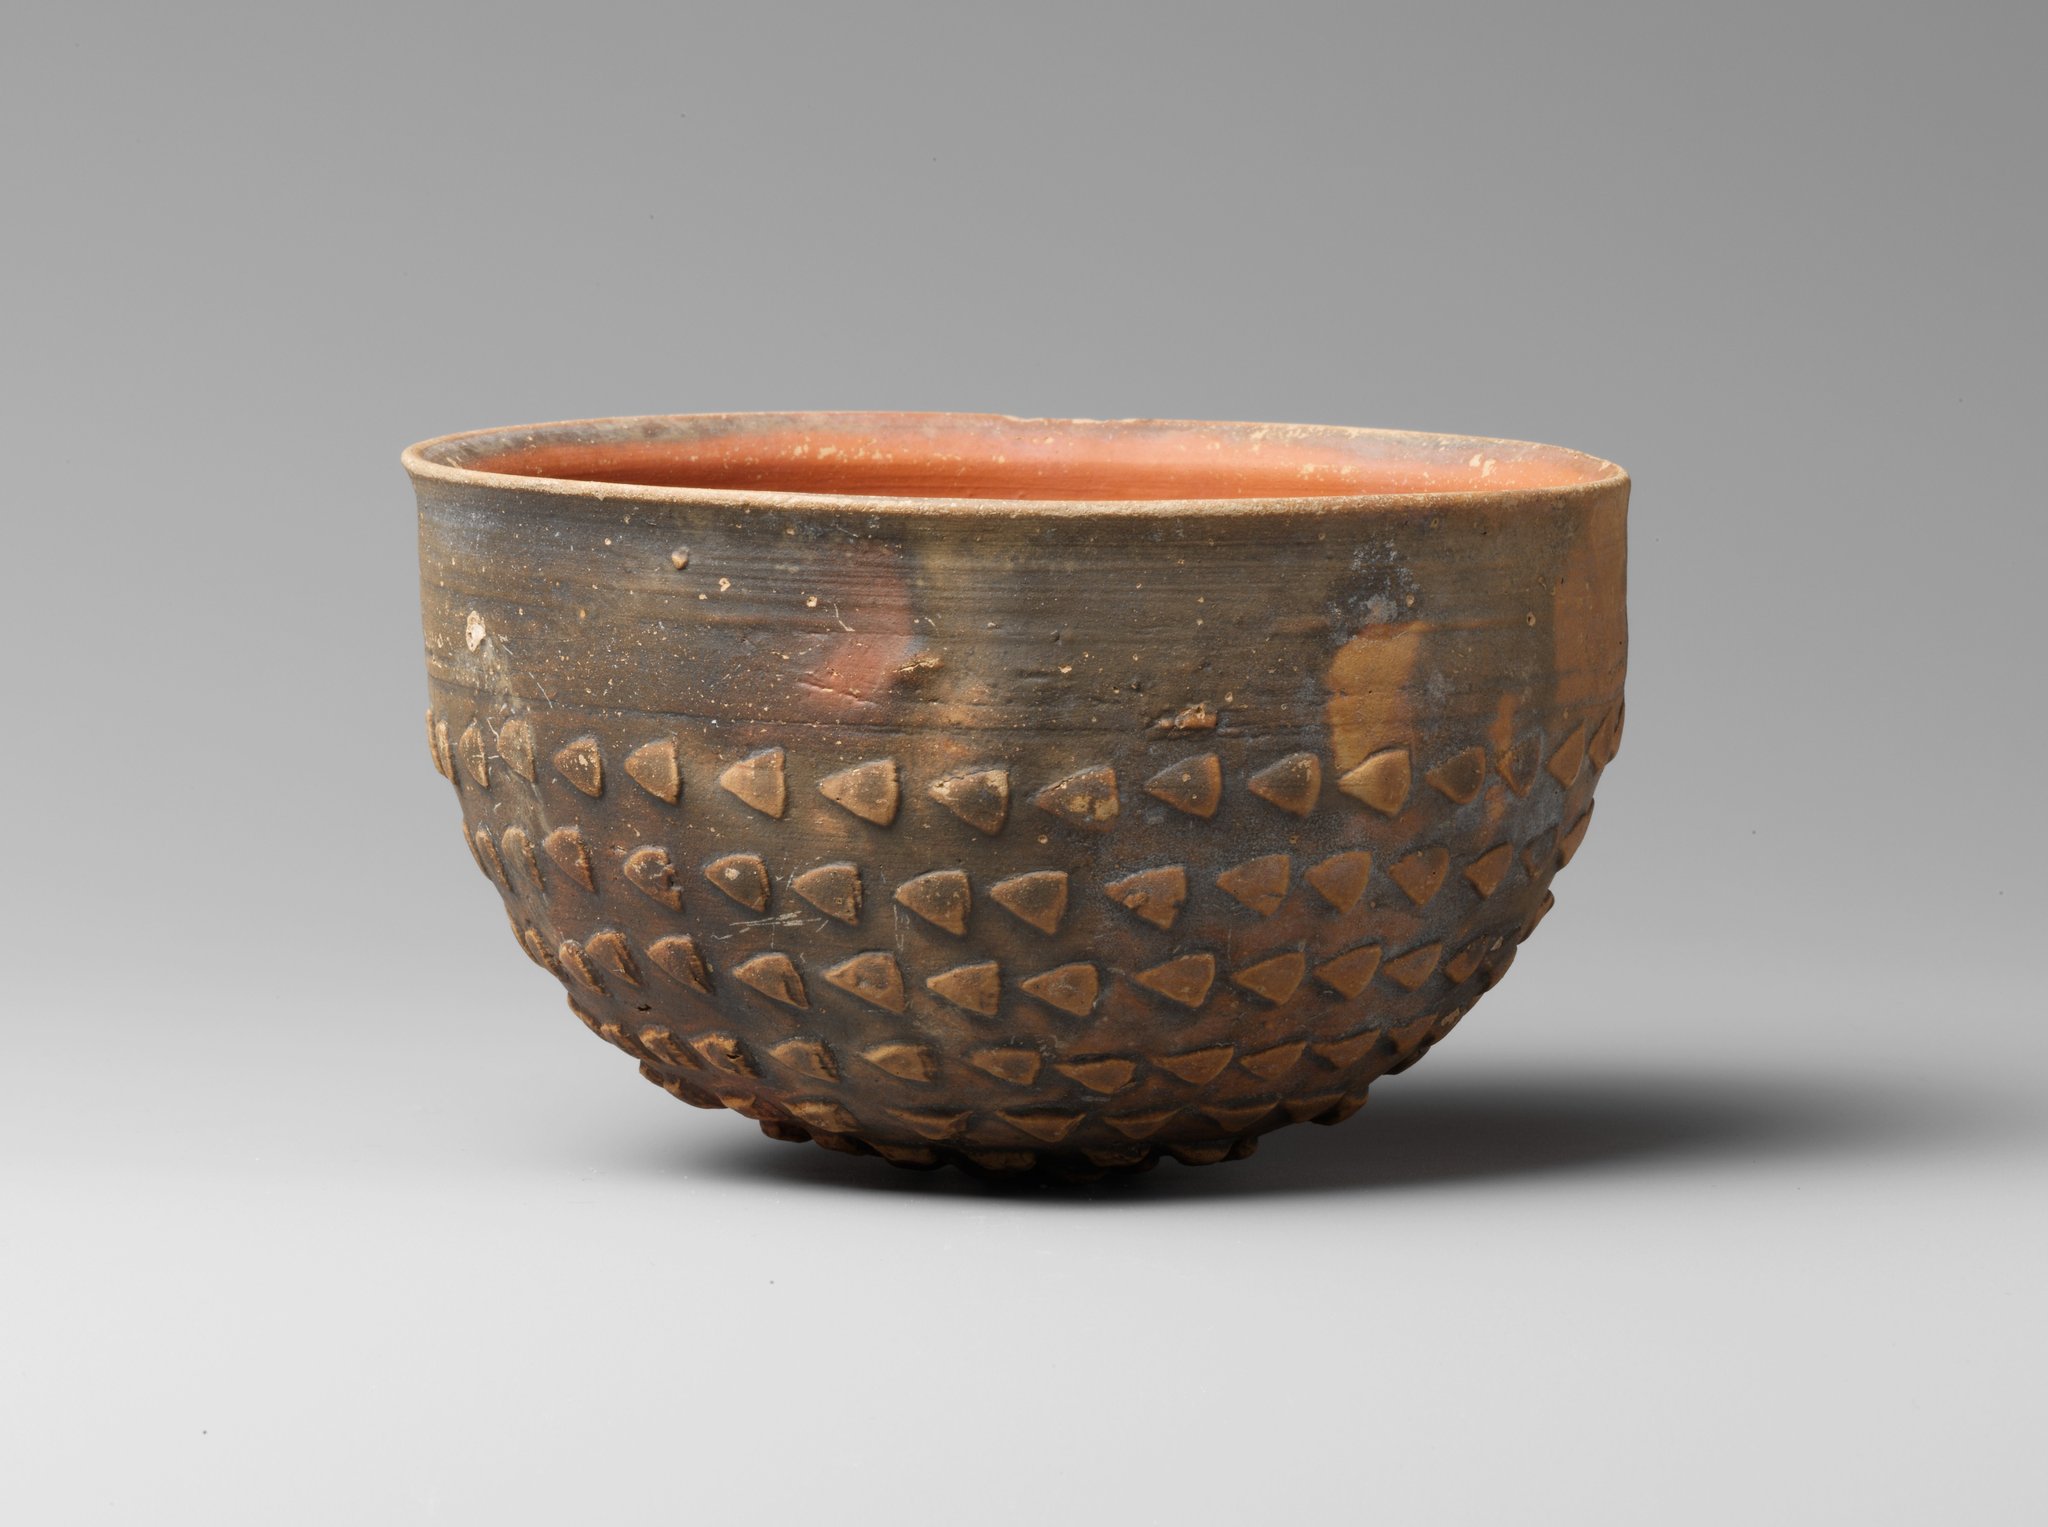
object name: bowl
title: Terracotta Megarian bowl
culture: greek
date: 234-35 BCE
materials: terracotta